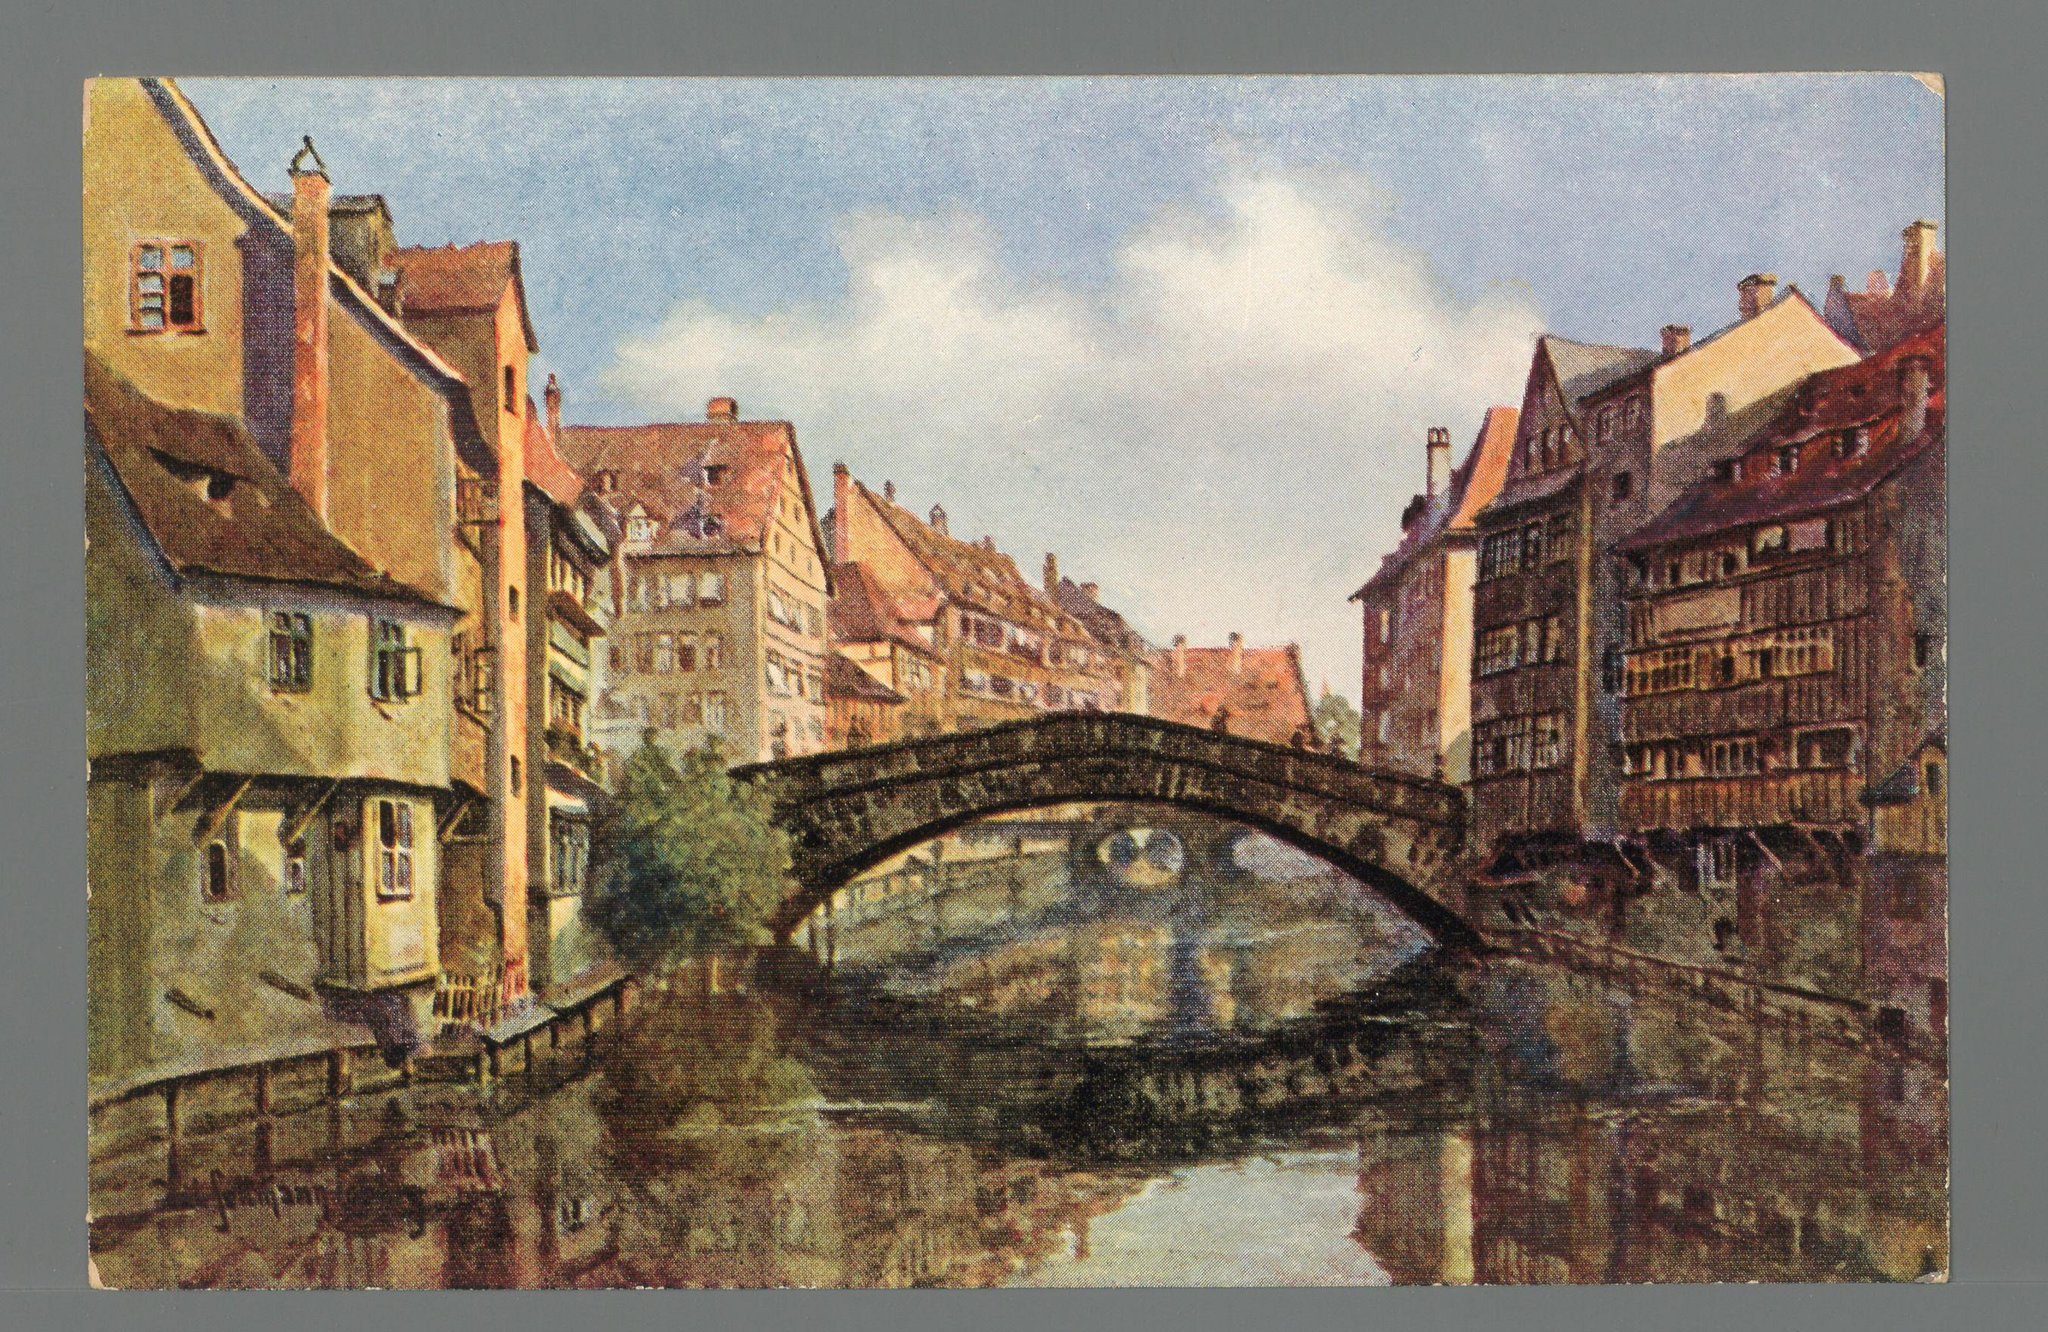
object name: reproduction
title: Nürnberg, Fleischbrücke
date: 1905-1909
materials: cardboard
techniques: writing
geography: nuremberg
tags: canals, waters (in city), bridge in city across river, canal, etc.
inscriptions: inscription: ‘Paul [...]mann [...]burg’